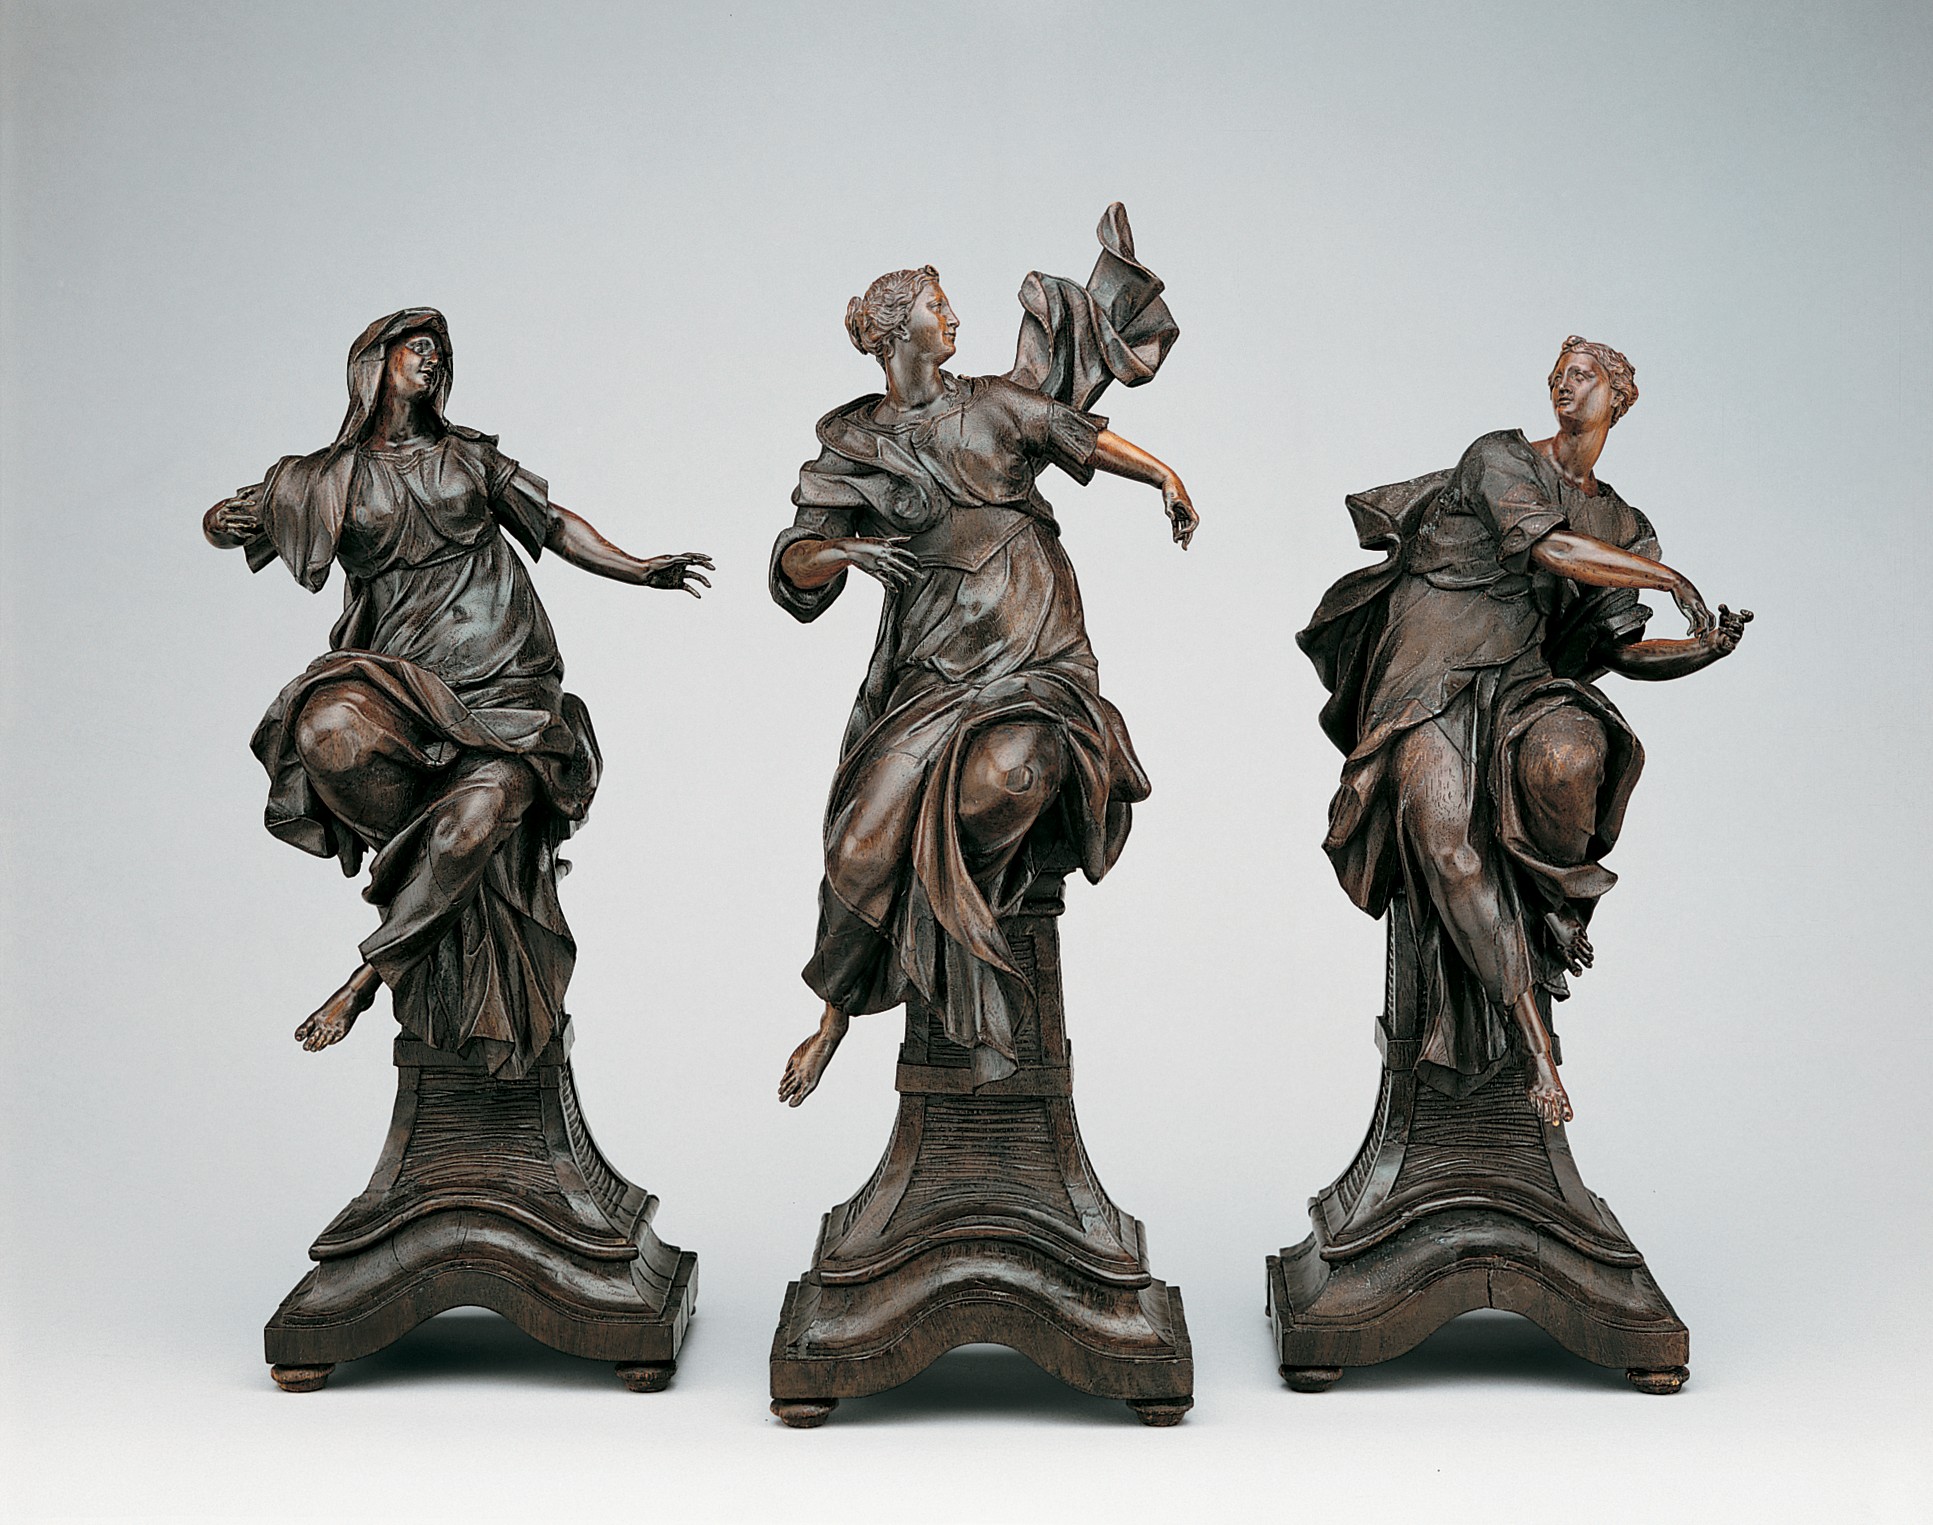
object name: statuette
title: Faith, Hope and Charity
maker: balthasar ferdinand moll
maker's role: maker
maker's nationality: austrian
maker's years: 1717-1785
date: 1739-1740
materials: ivory, wood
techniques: stain